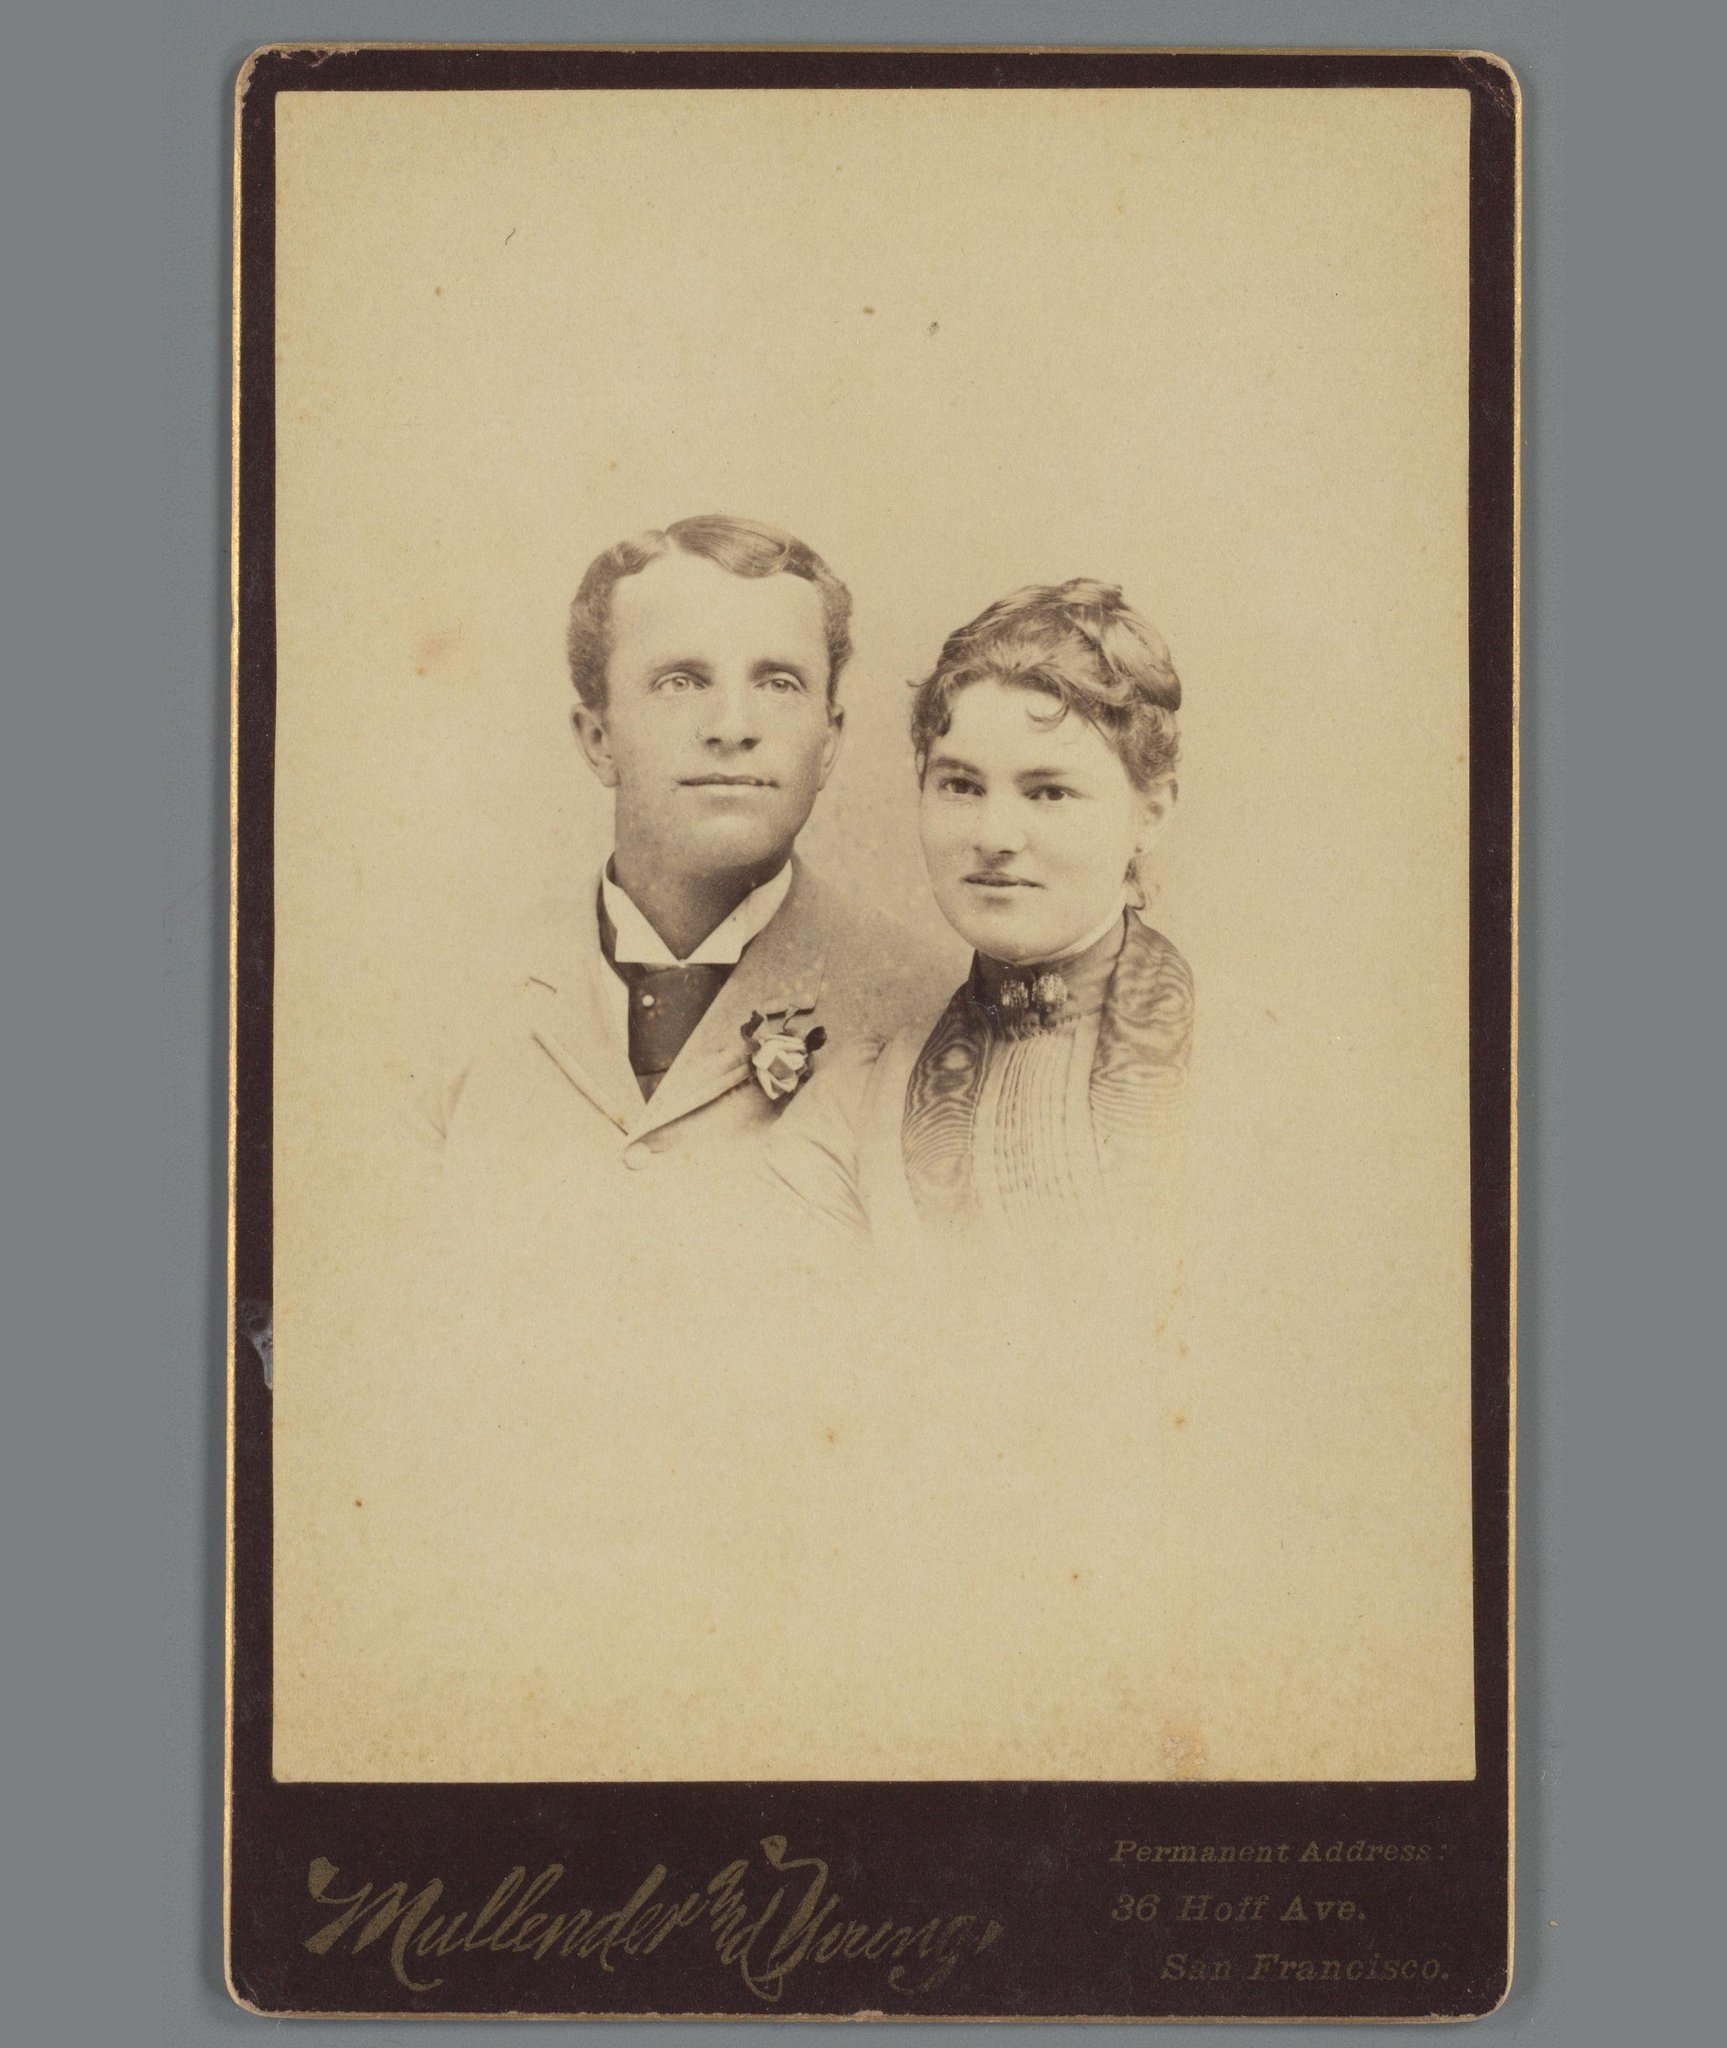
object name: cabinet photograph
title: Portret van een onbekende man en vrouw uit de familie en de kring van Eugene van Delden en Belle van Delden-Denninghof Stelling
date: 1870-1900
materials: cardboard, paper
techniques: albumen print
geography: san francisco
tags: couple of lovers, historical persons not known by name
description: Portret uit de kring van Eugene van Delden (Hartapoera, 1865 - Den Haag, 1954) en Belle van Delden-Denninghof Stelling (Batavia, 1870 - Den Haag, 1947).